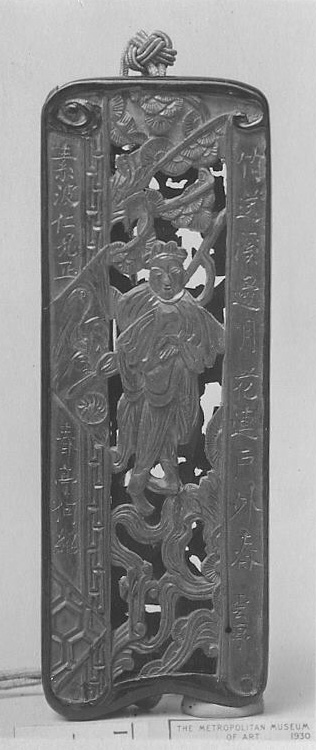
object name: card case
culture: chinese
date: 1701-1900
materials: wood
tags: men